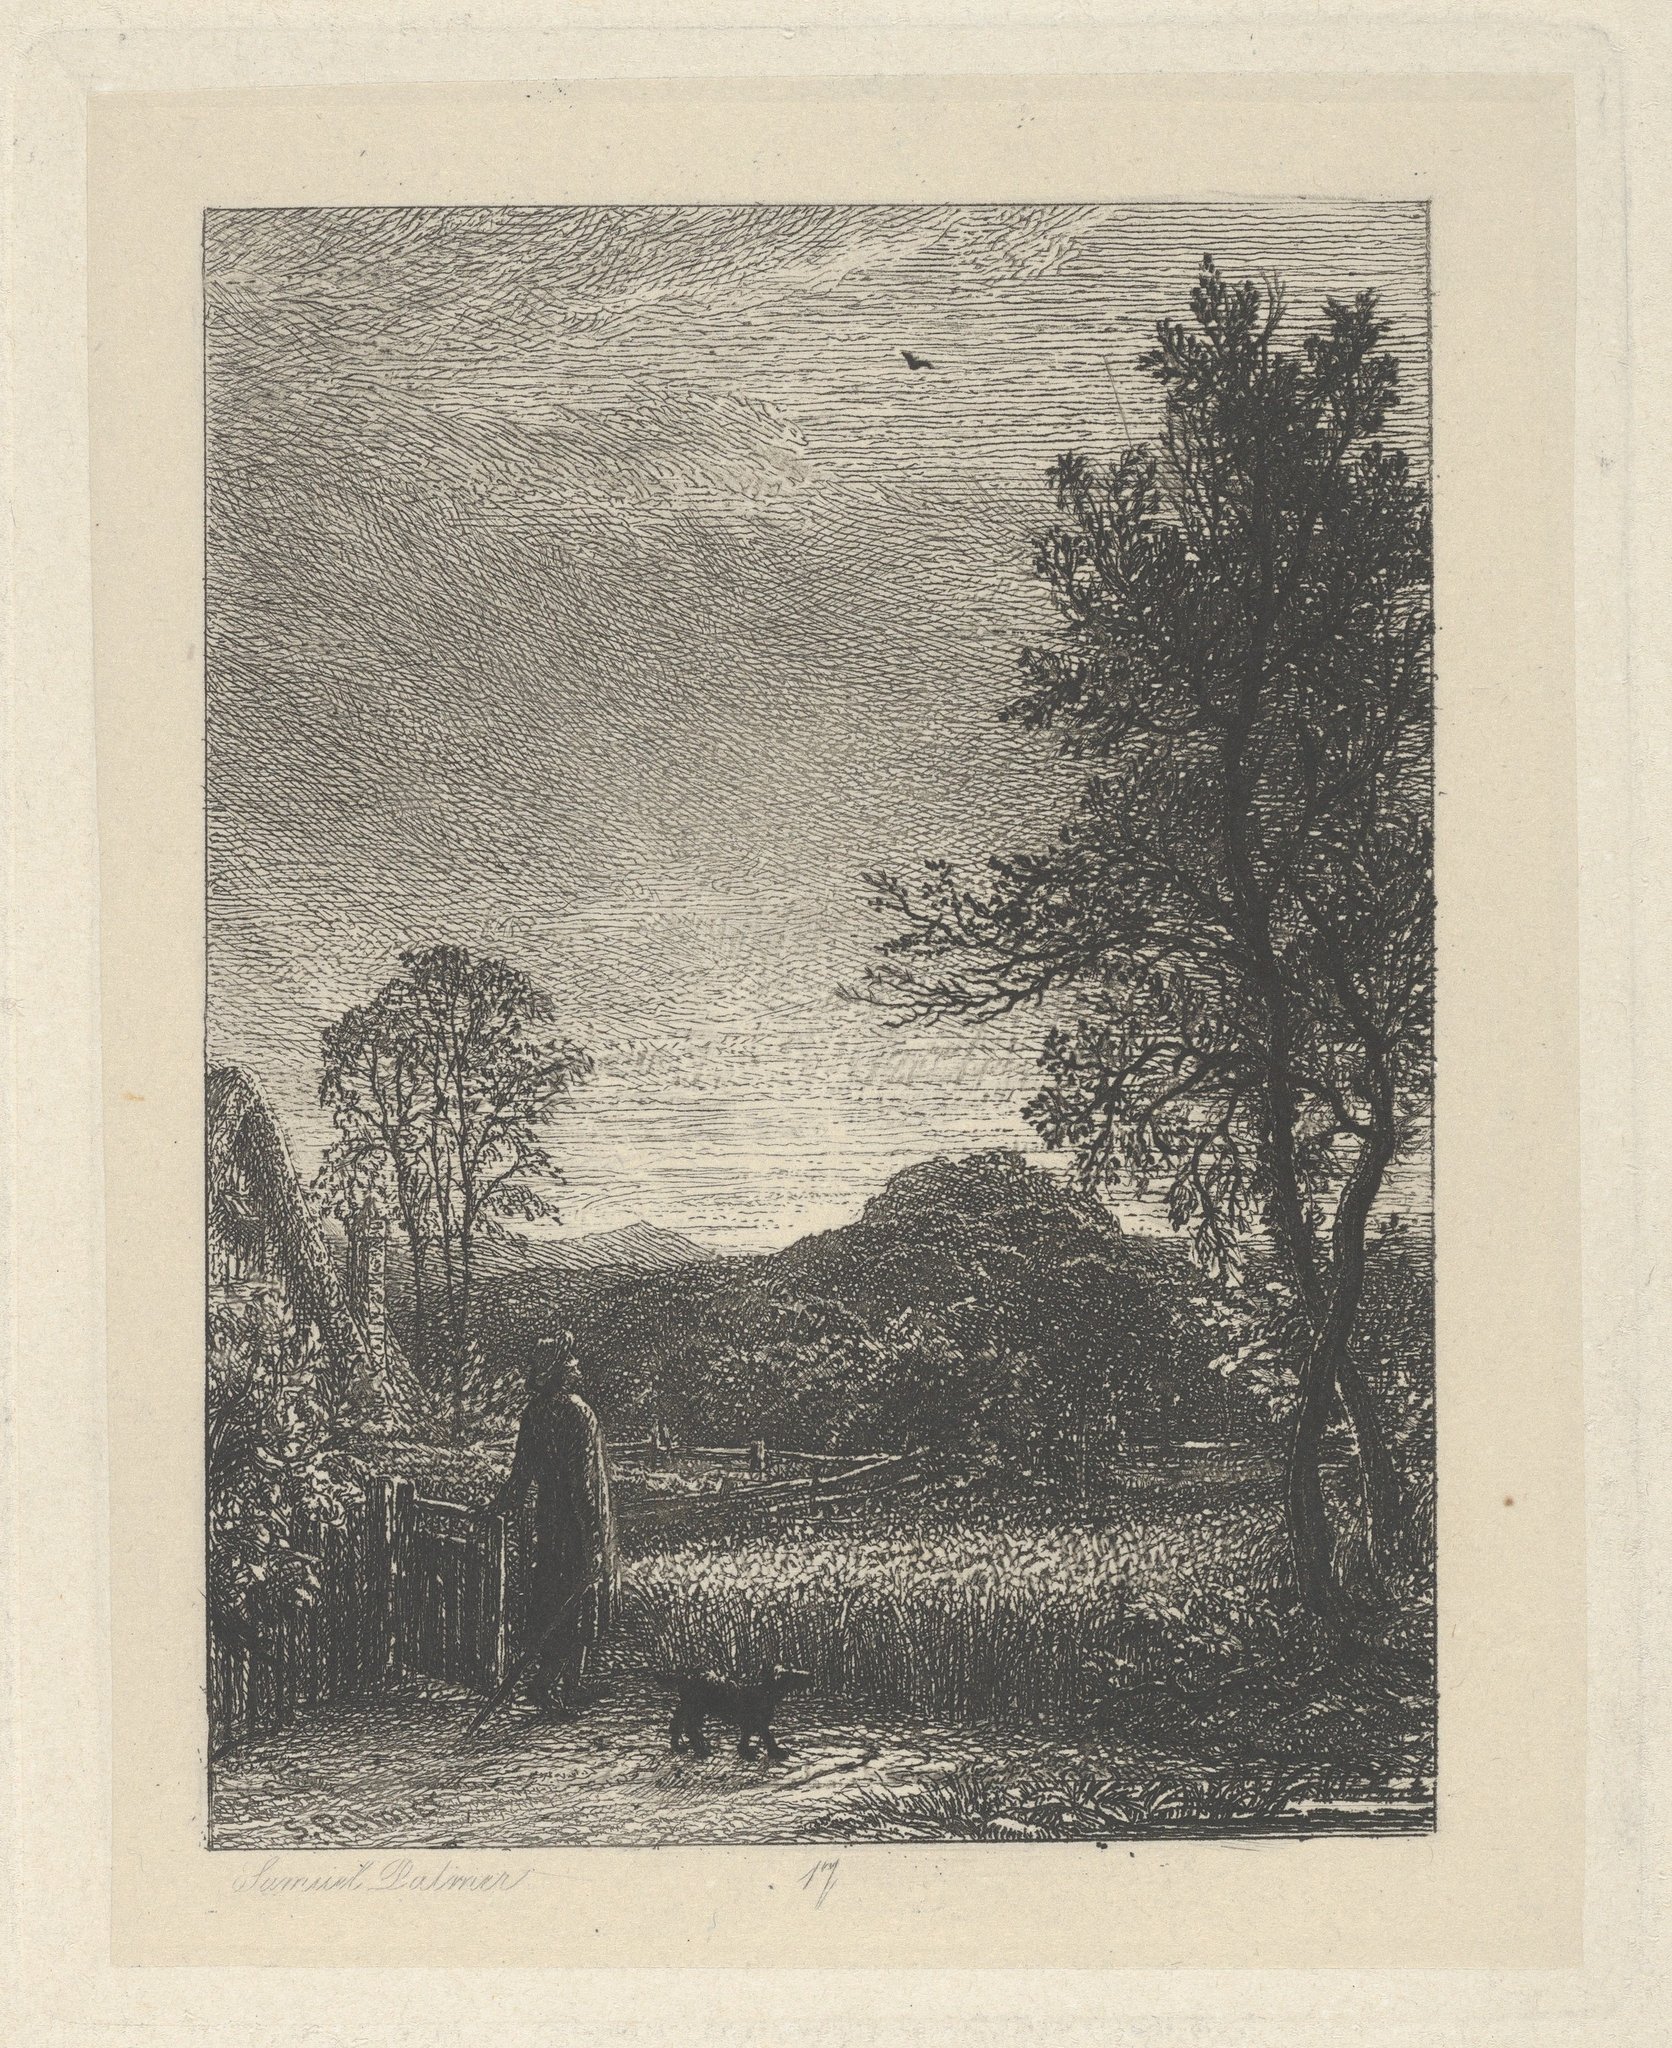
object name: print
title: The Skylark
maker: samuel palmer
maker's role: artist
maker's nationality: british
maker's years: 1805-1881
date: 1850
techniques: printmaking, etching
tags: birds,men,dogs,trees